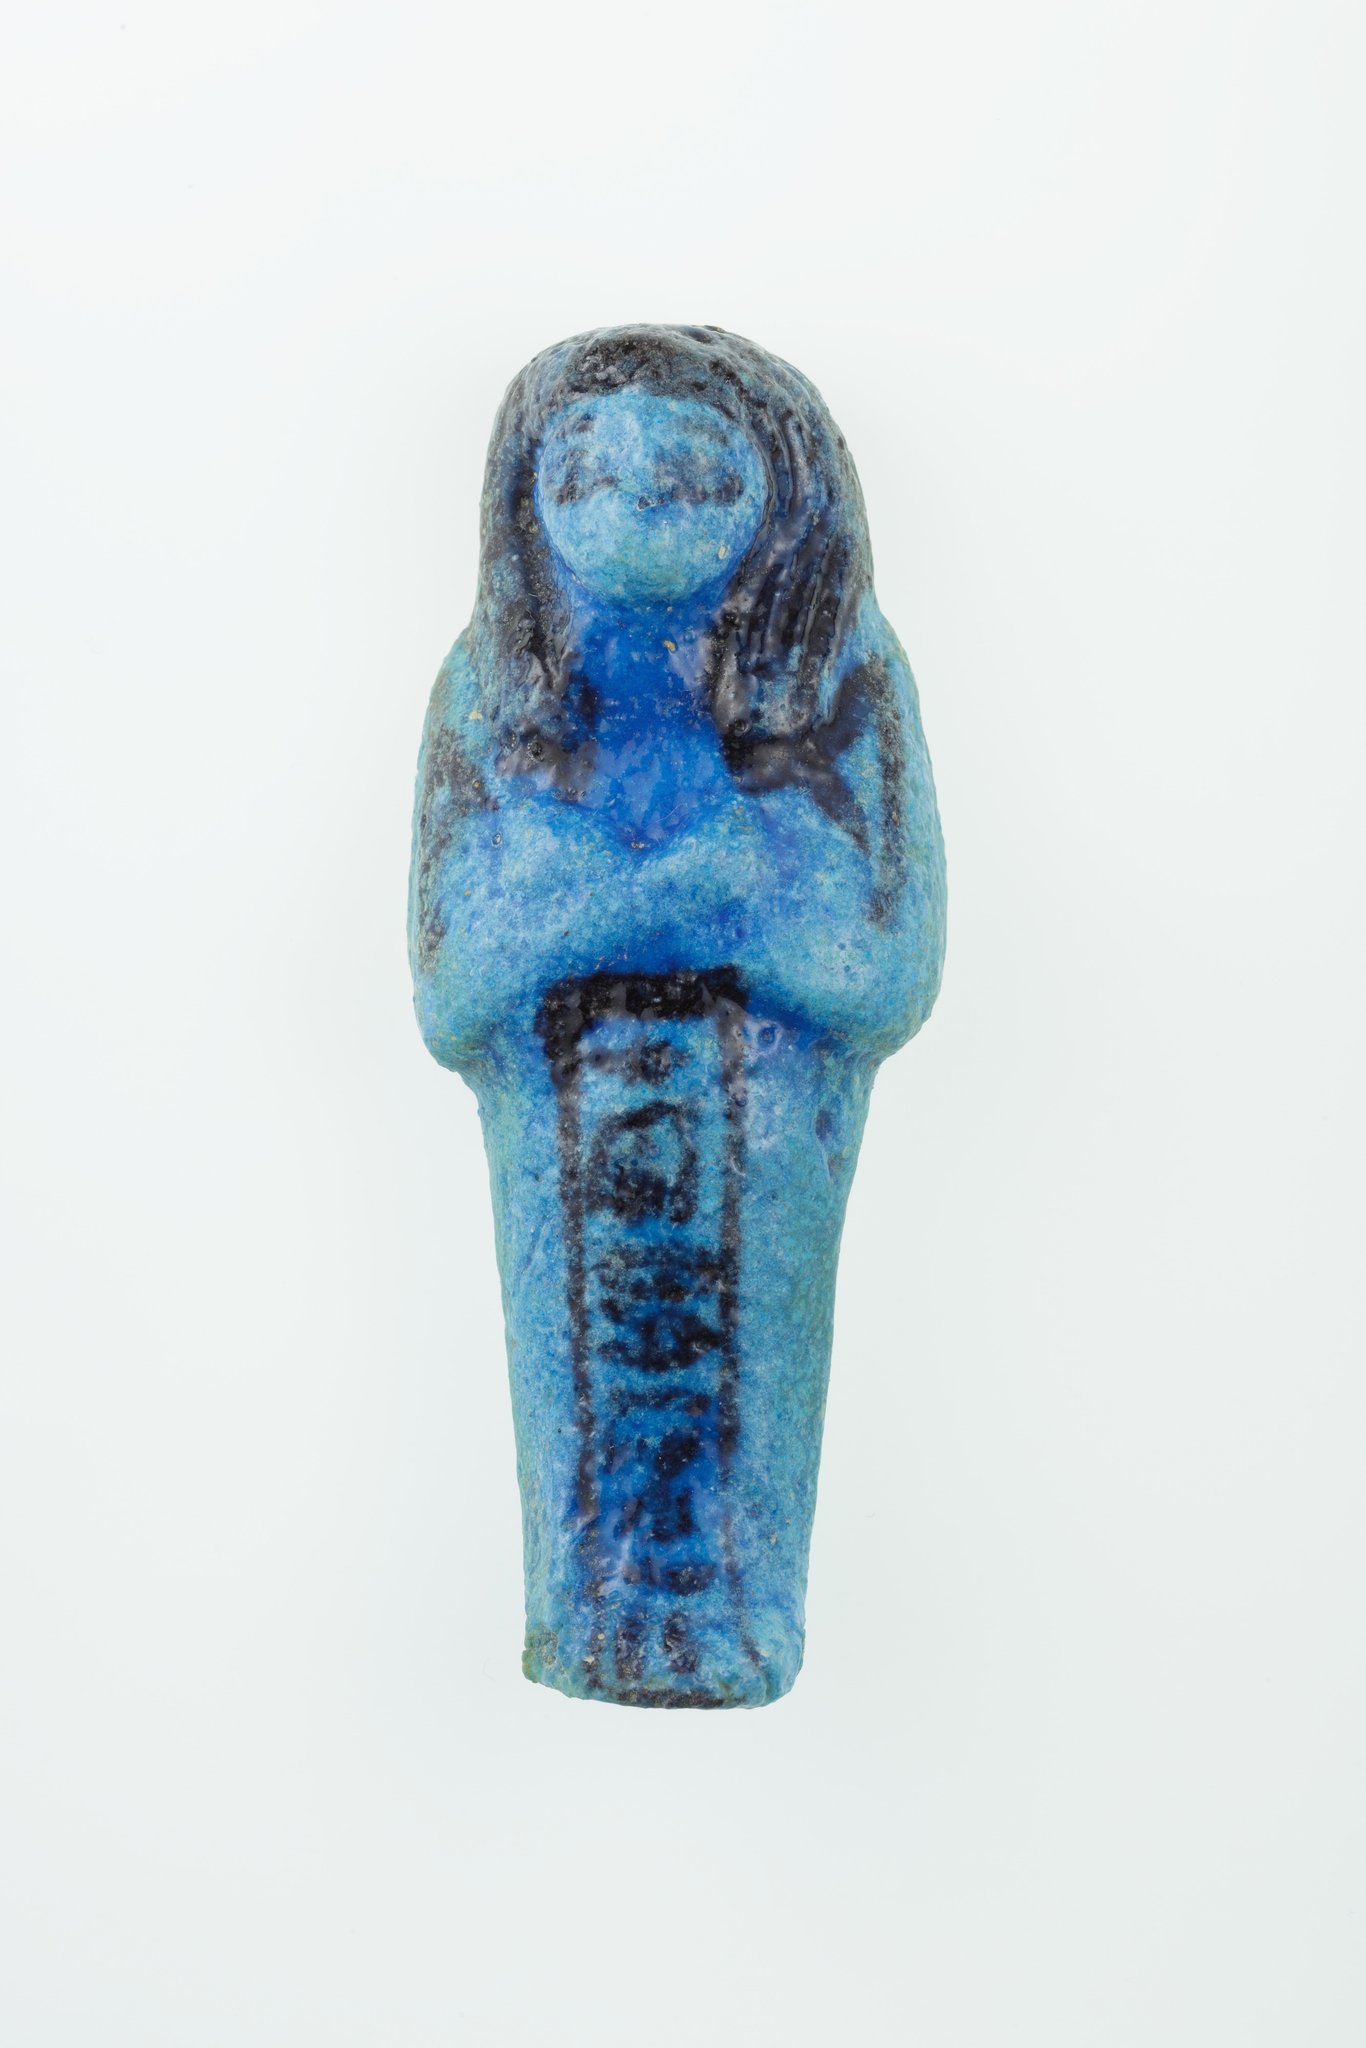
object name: shabti, worker, nauny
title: Worker Shabti of Nauny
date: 1050 BCE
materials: faience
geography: egypt